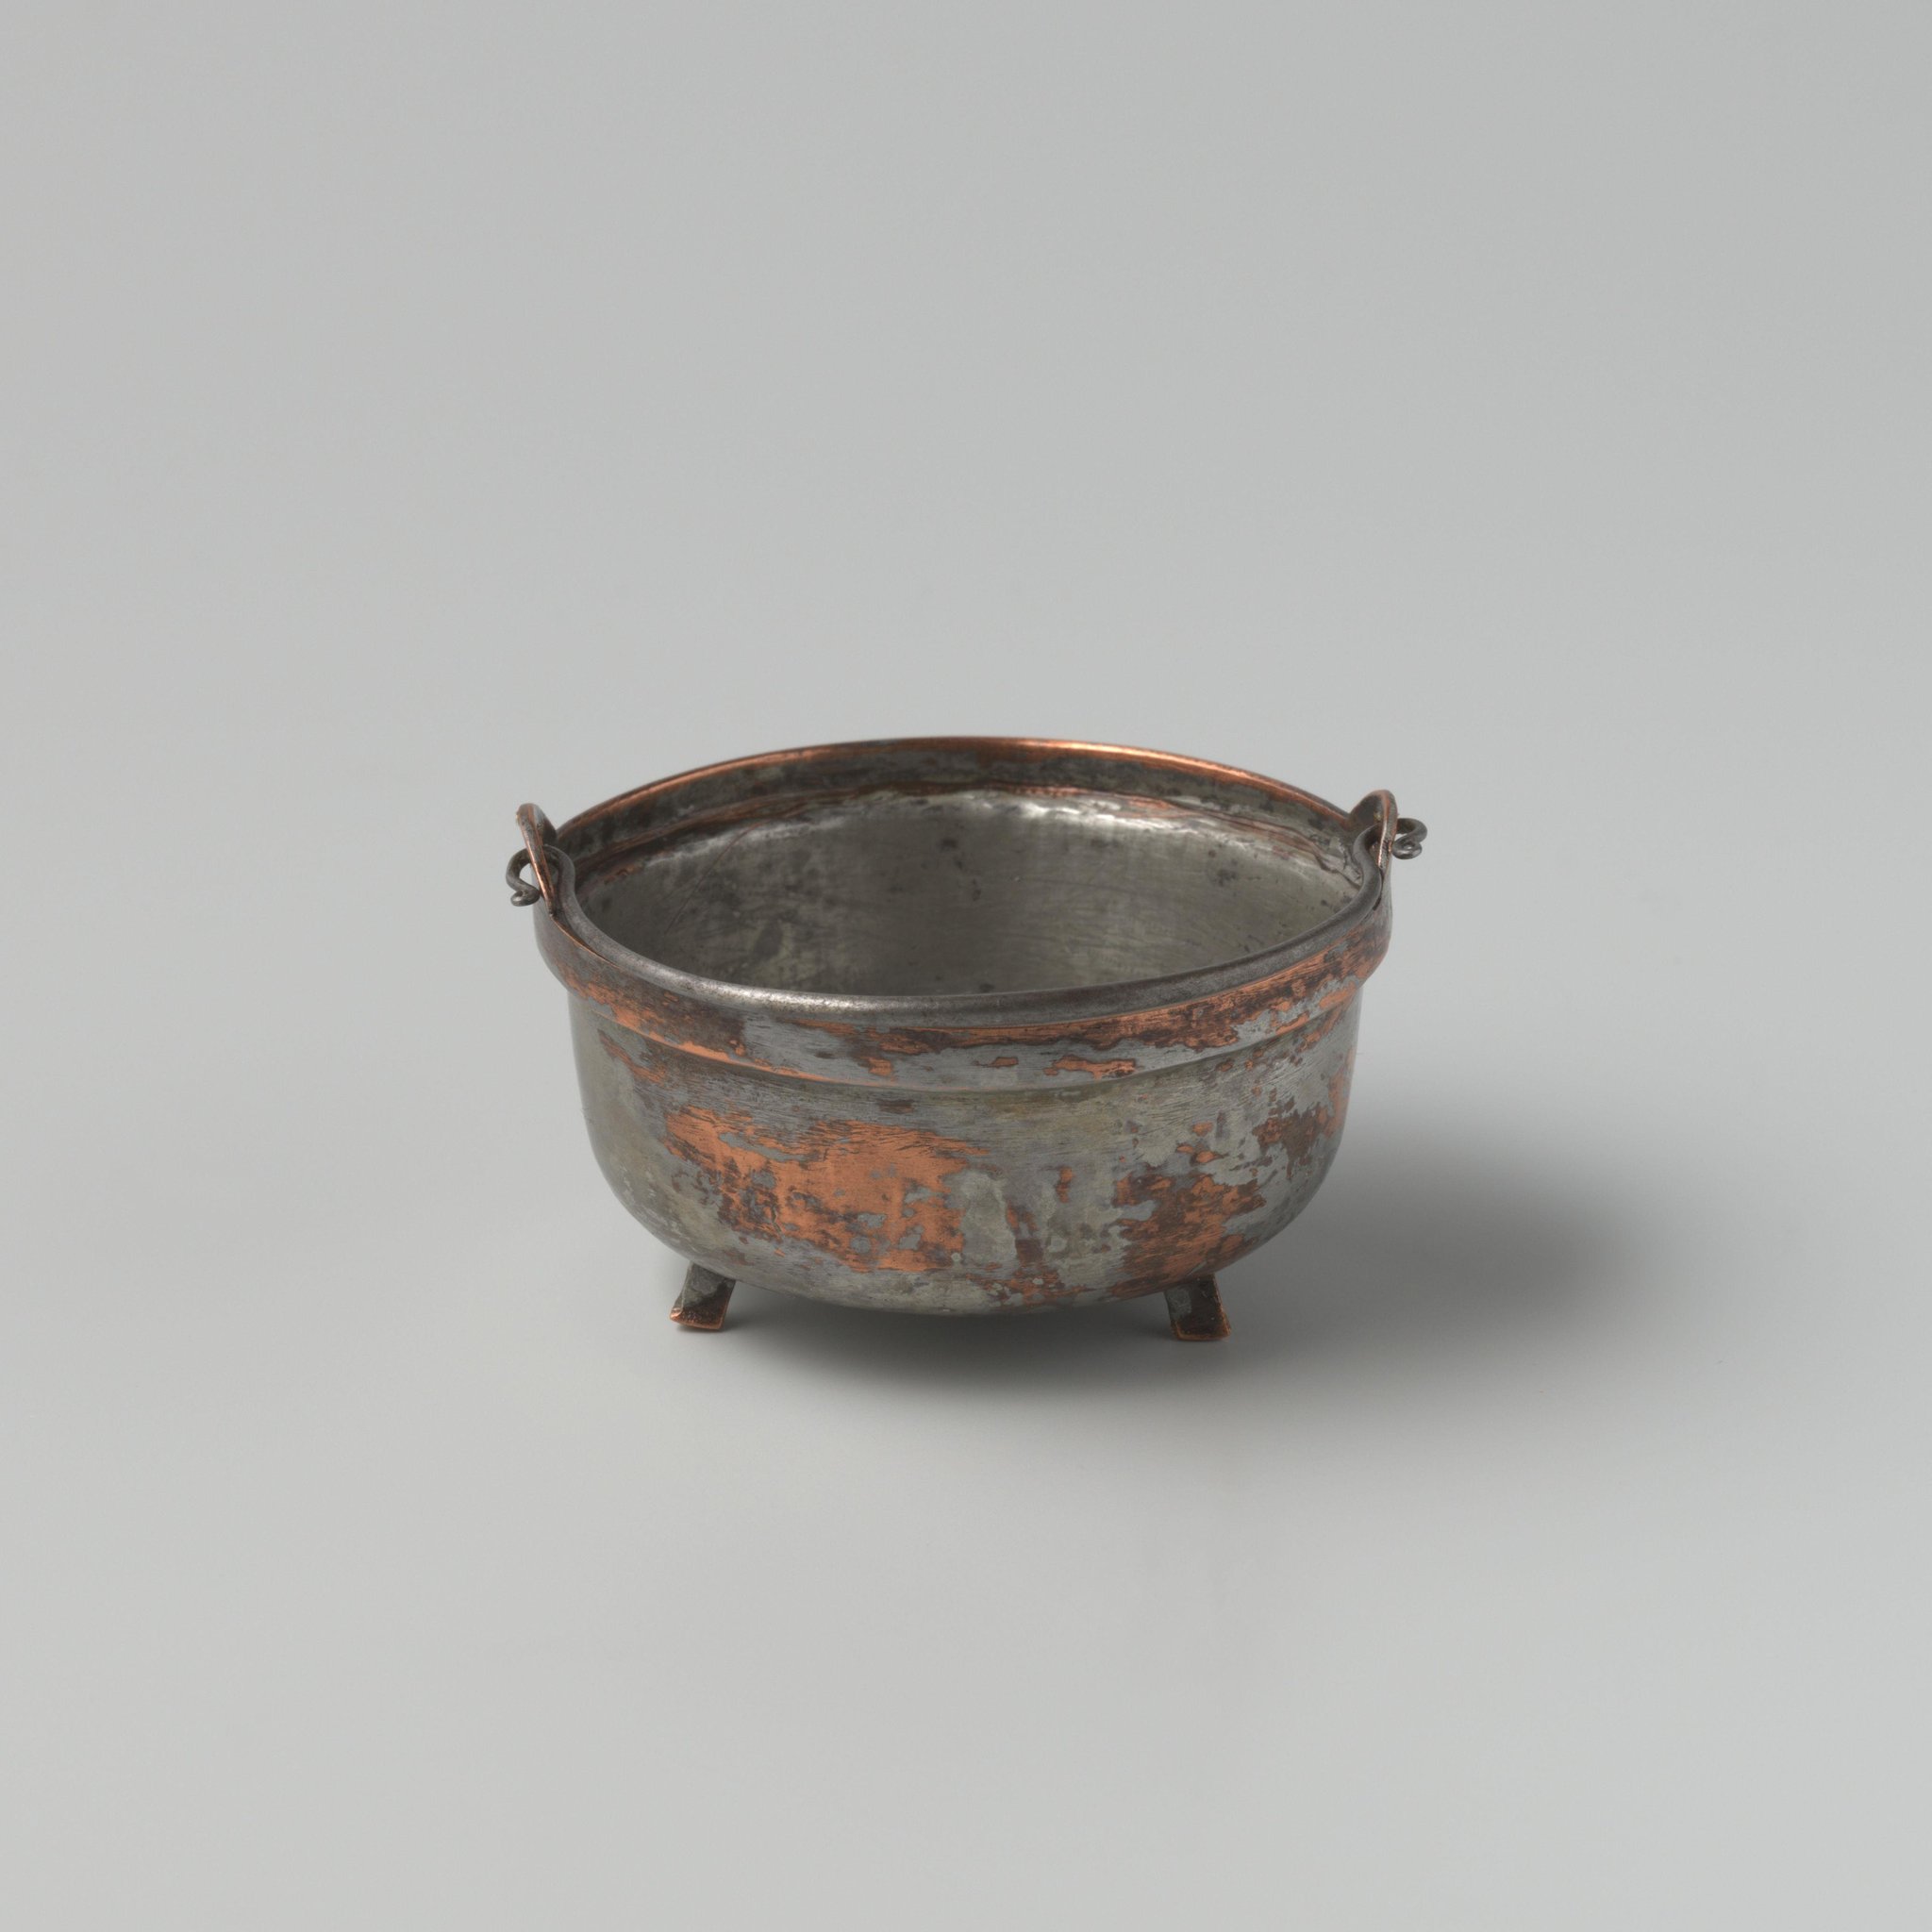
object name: boiler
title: Wijde kookketel van koper, van binnen en buiten vertind, op drie lage, driehoekige pootjes; de ketel kan boven het vuur gehangen worden met een smeed ijzeren hengsel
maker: Anonymous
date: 1690-1710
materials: copper, iron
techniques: tinning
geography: amsterdam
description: Wijde kookketel van koper, van binnen en buiten vertind, op drie lage, driehoekige pootjes; de ketel kan boven het vuur gehangen worden met een smeed ijzeren hengsel.